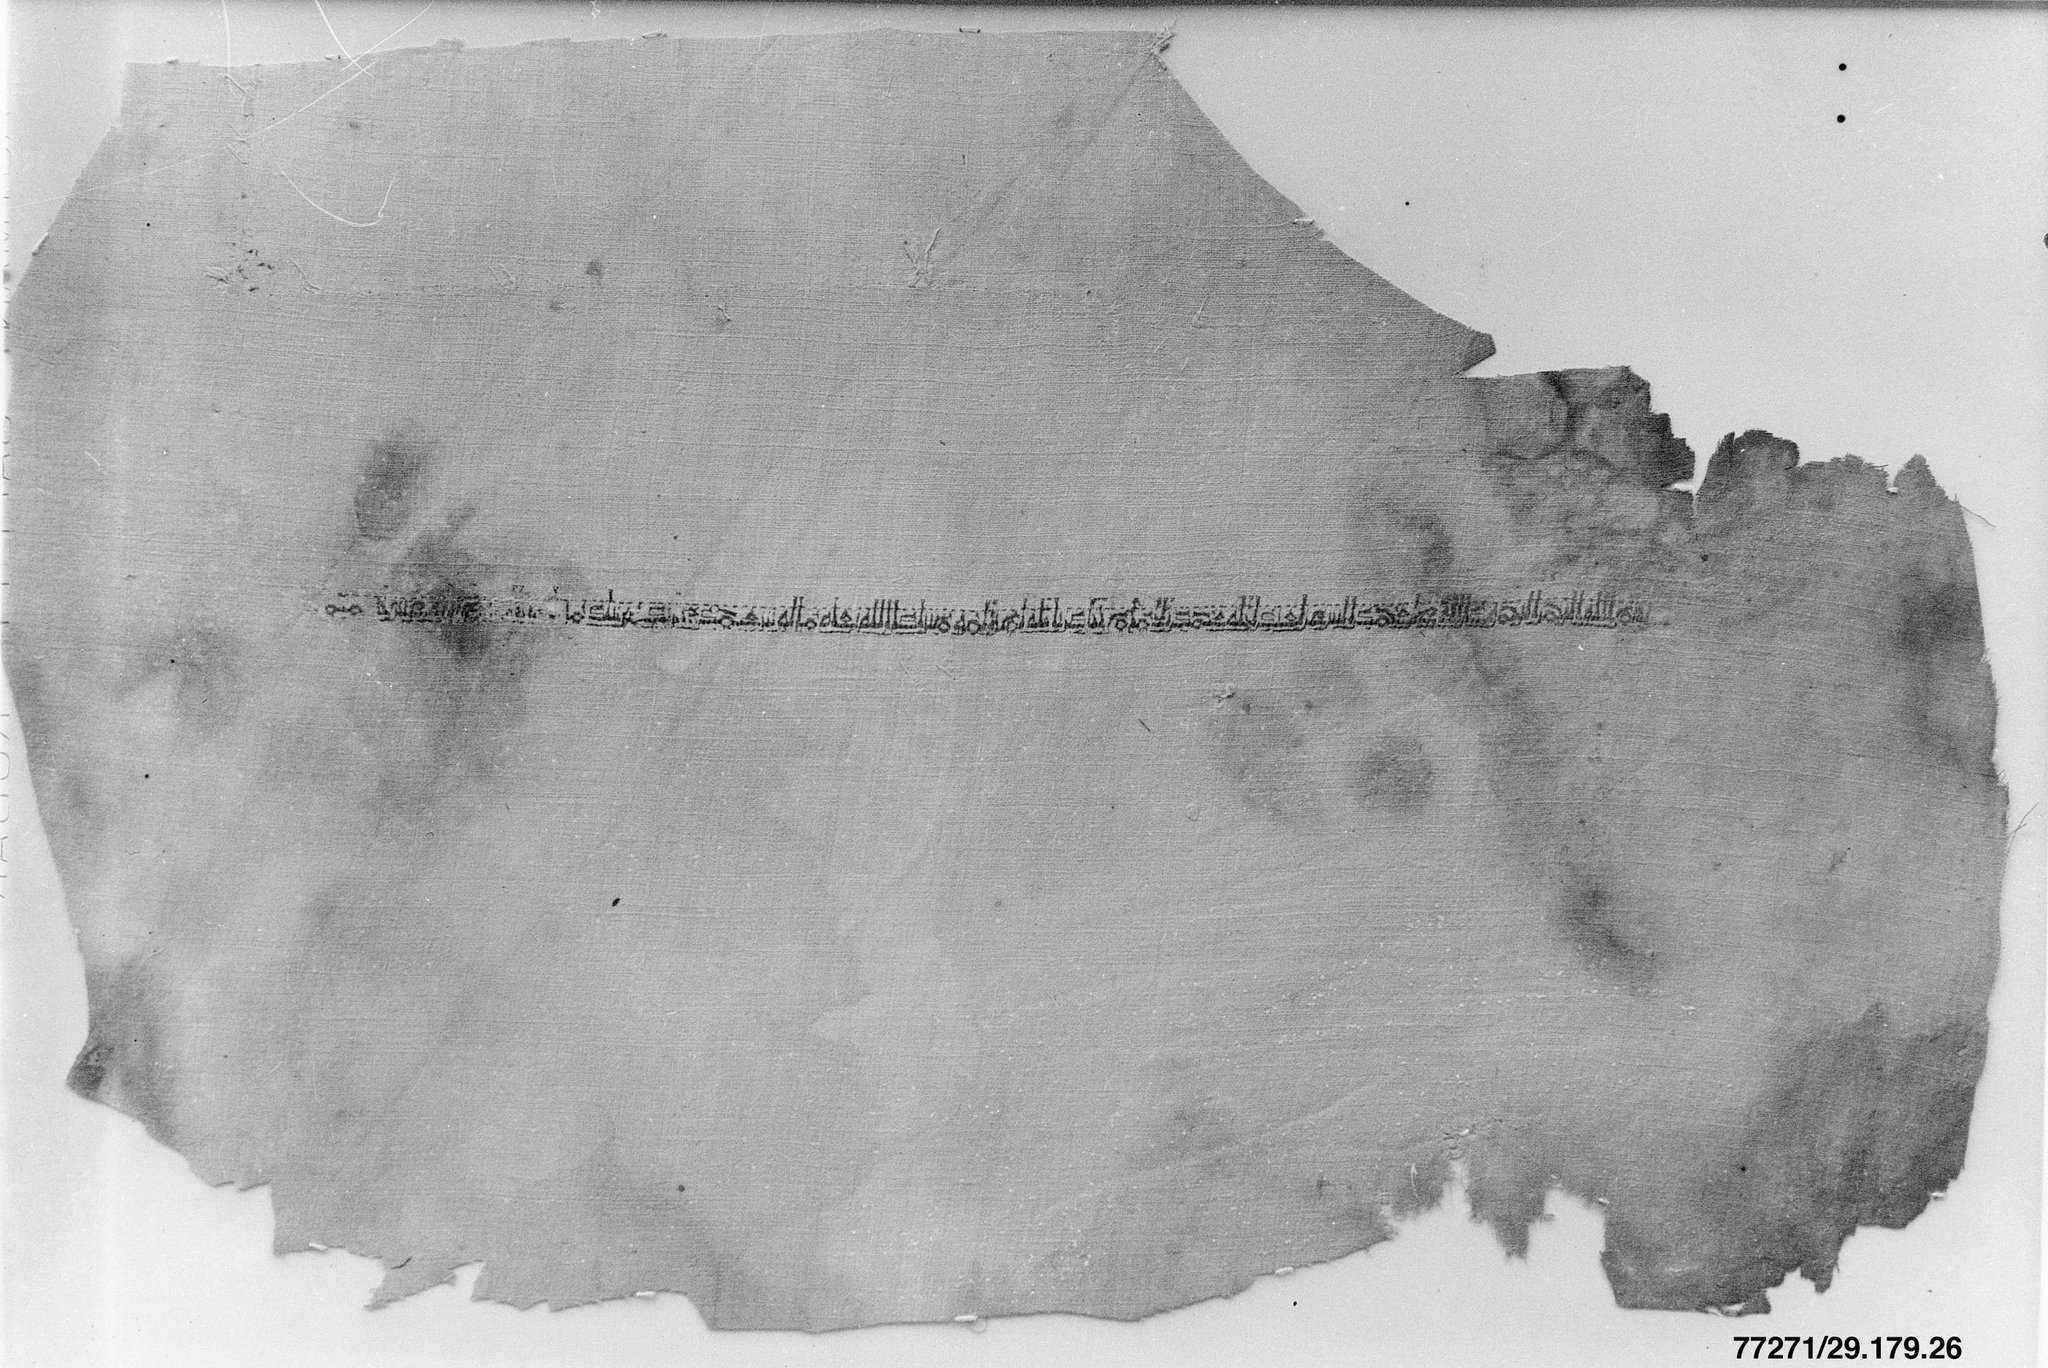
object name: textile fragment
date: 934-940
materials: linen, silk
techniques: embroidery, weave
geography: egypt